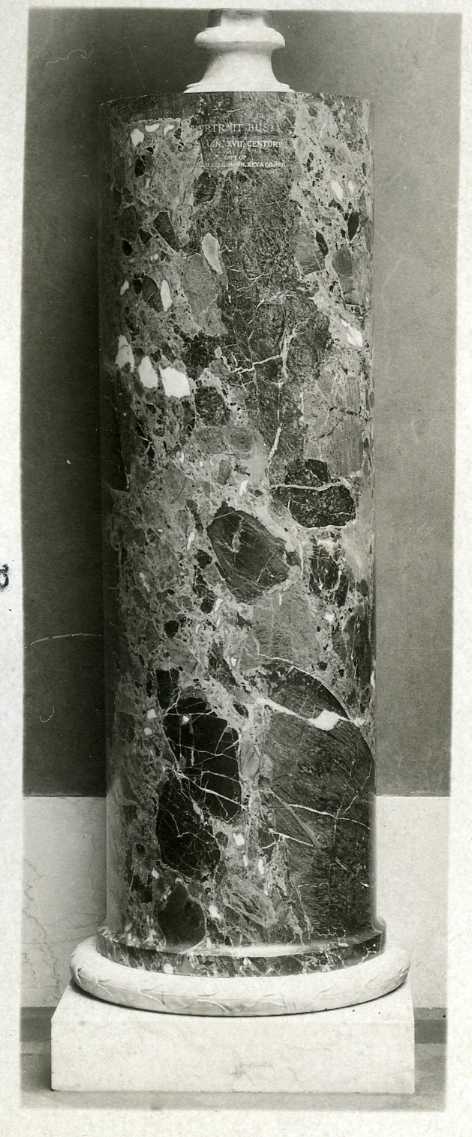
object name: column base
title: Column with base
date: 1501-1600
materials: marble